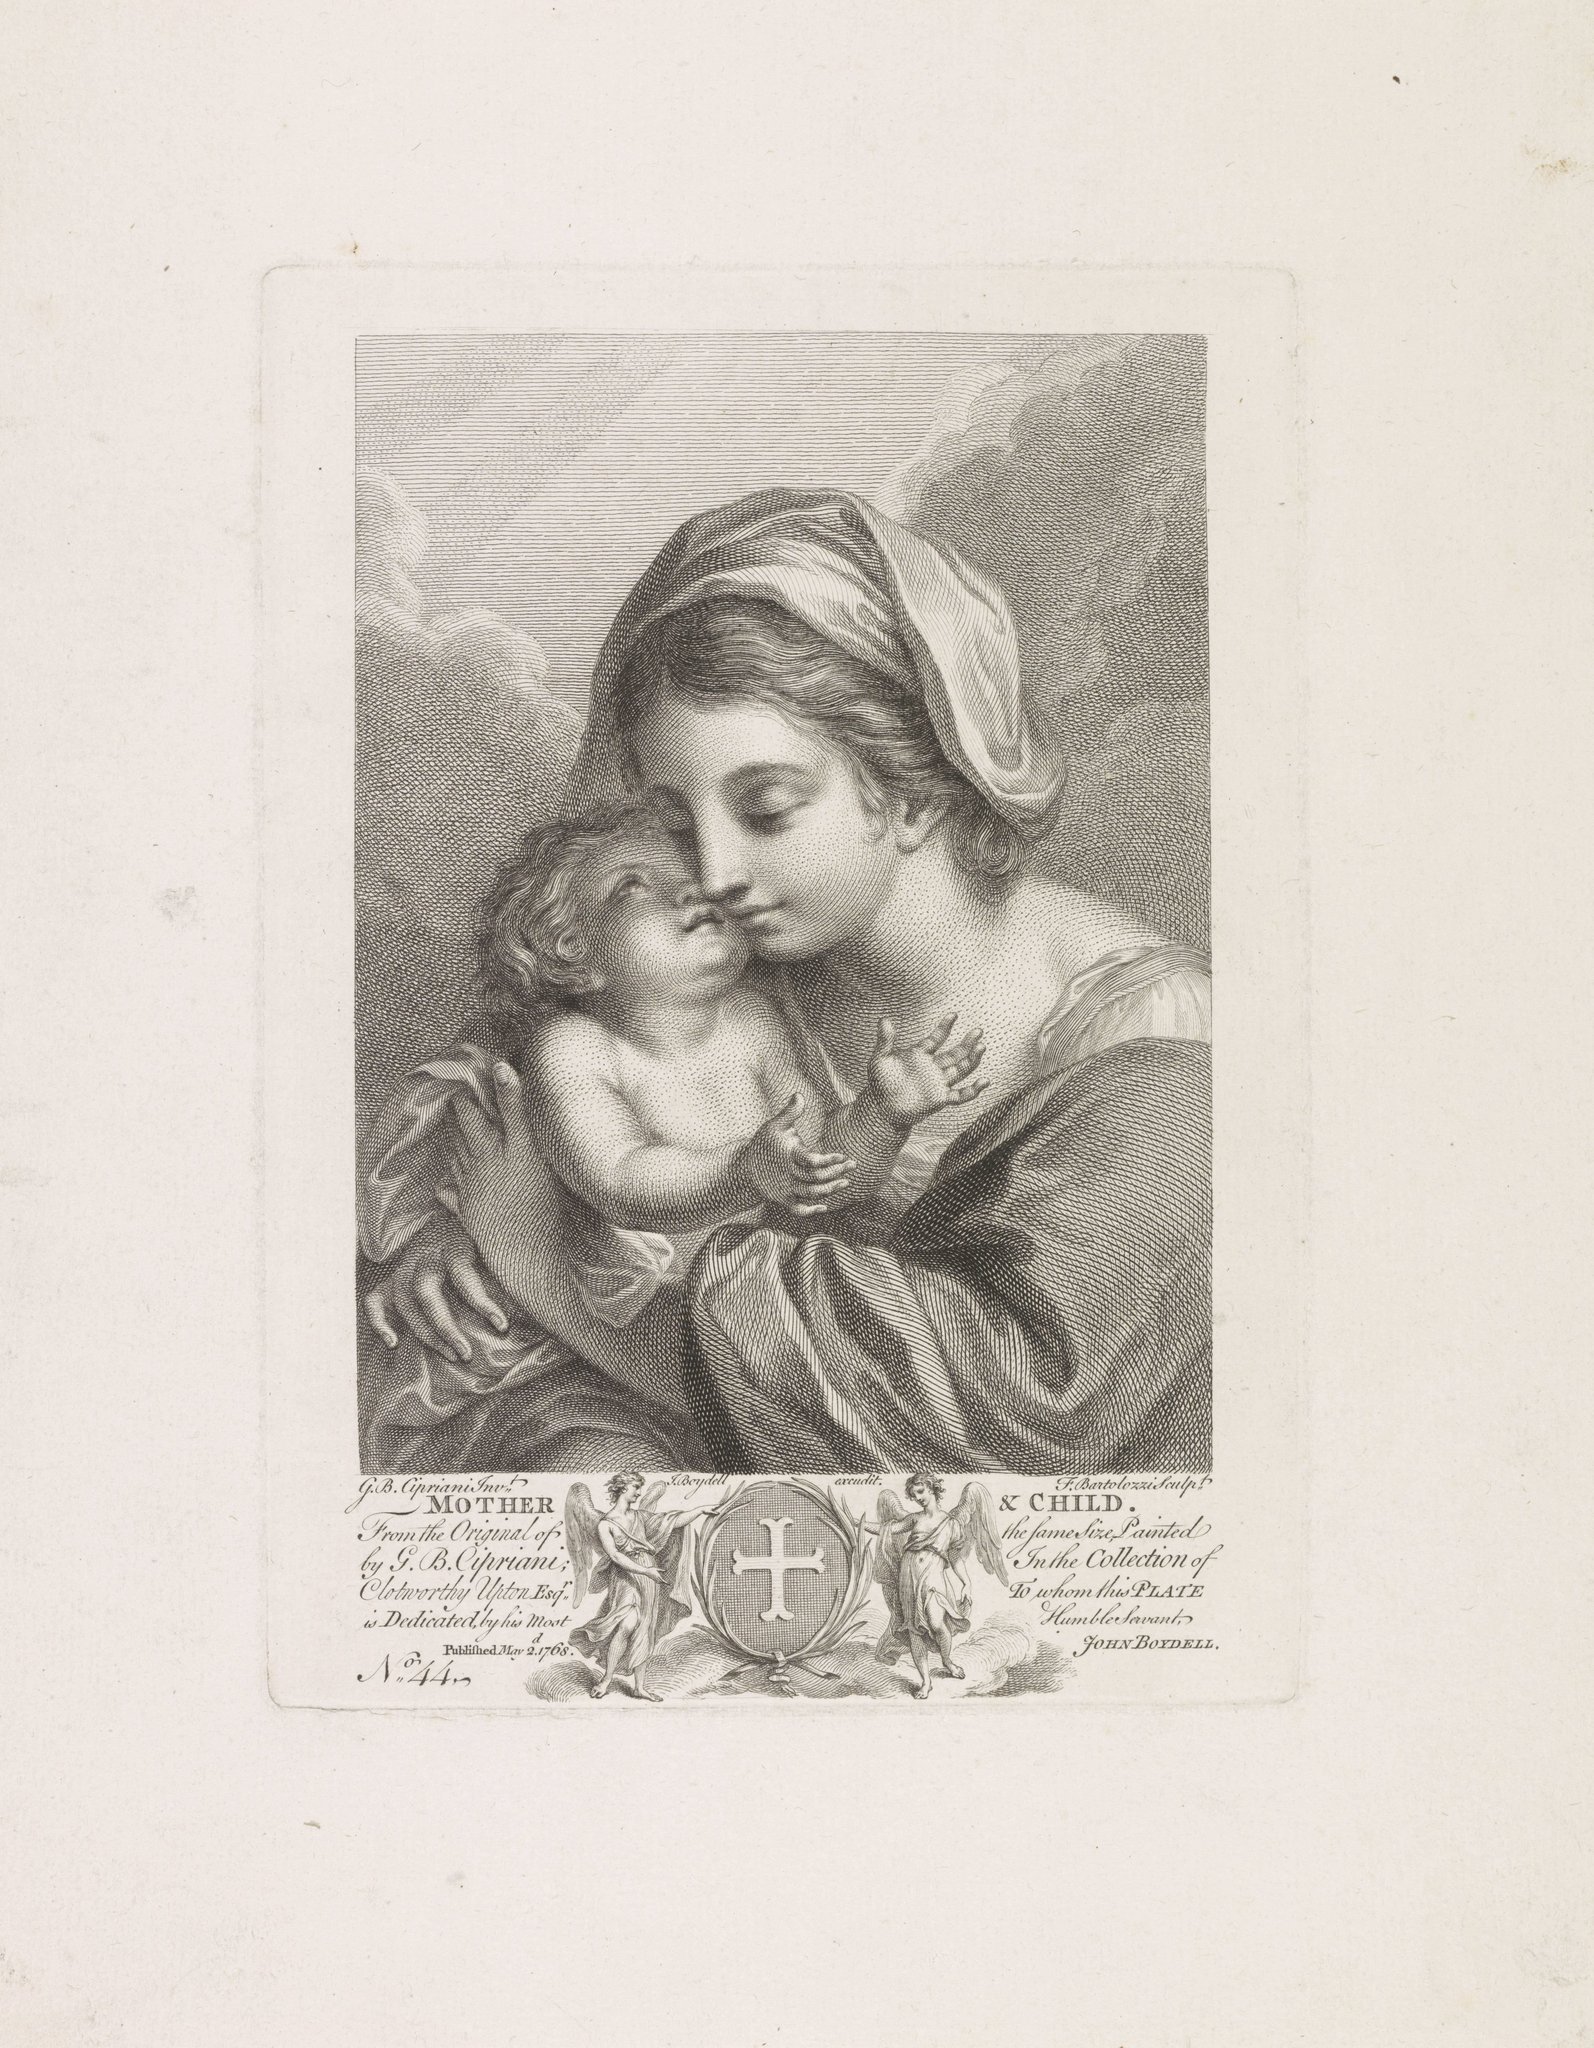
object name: print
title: Maria met kind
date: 1768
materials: paper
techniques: engraving, etching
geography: italy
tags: madonna: i.e. mary with the christ-child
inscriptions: collector's mark: Lugt 240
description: Maria met het Christuskind in haar armen. In de ondermarge tekst en een schild geflankeerd door engelen. Genummerd linksonder: No. 44.